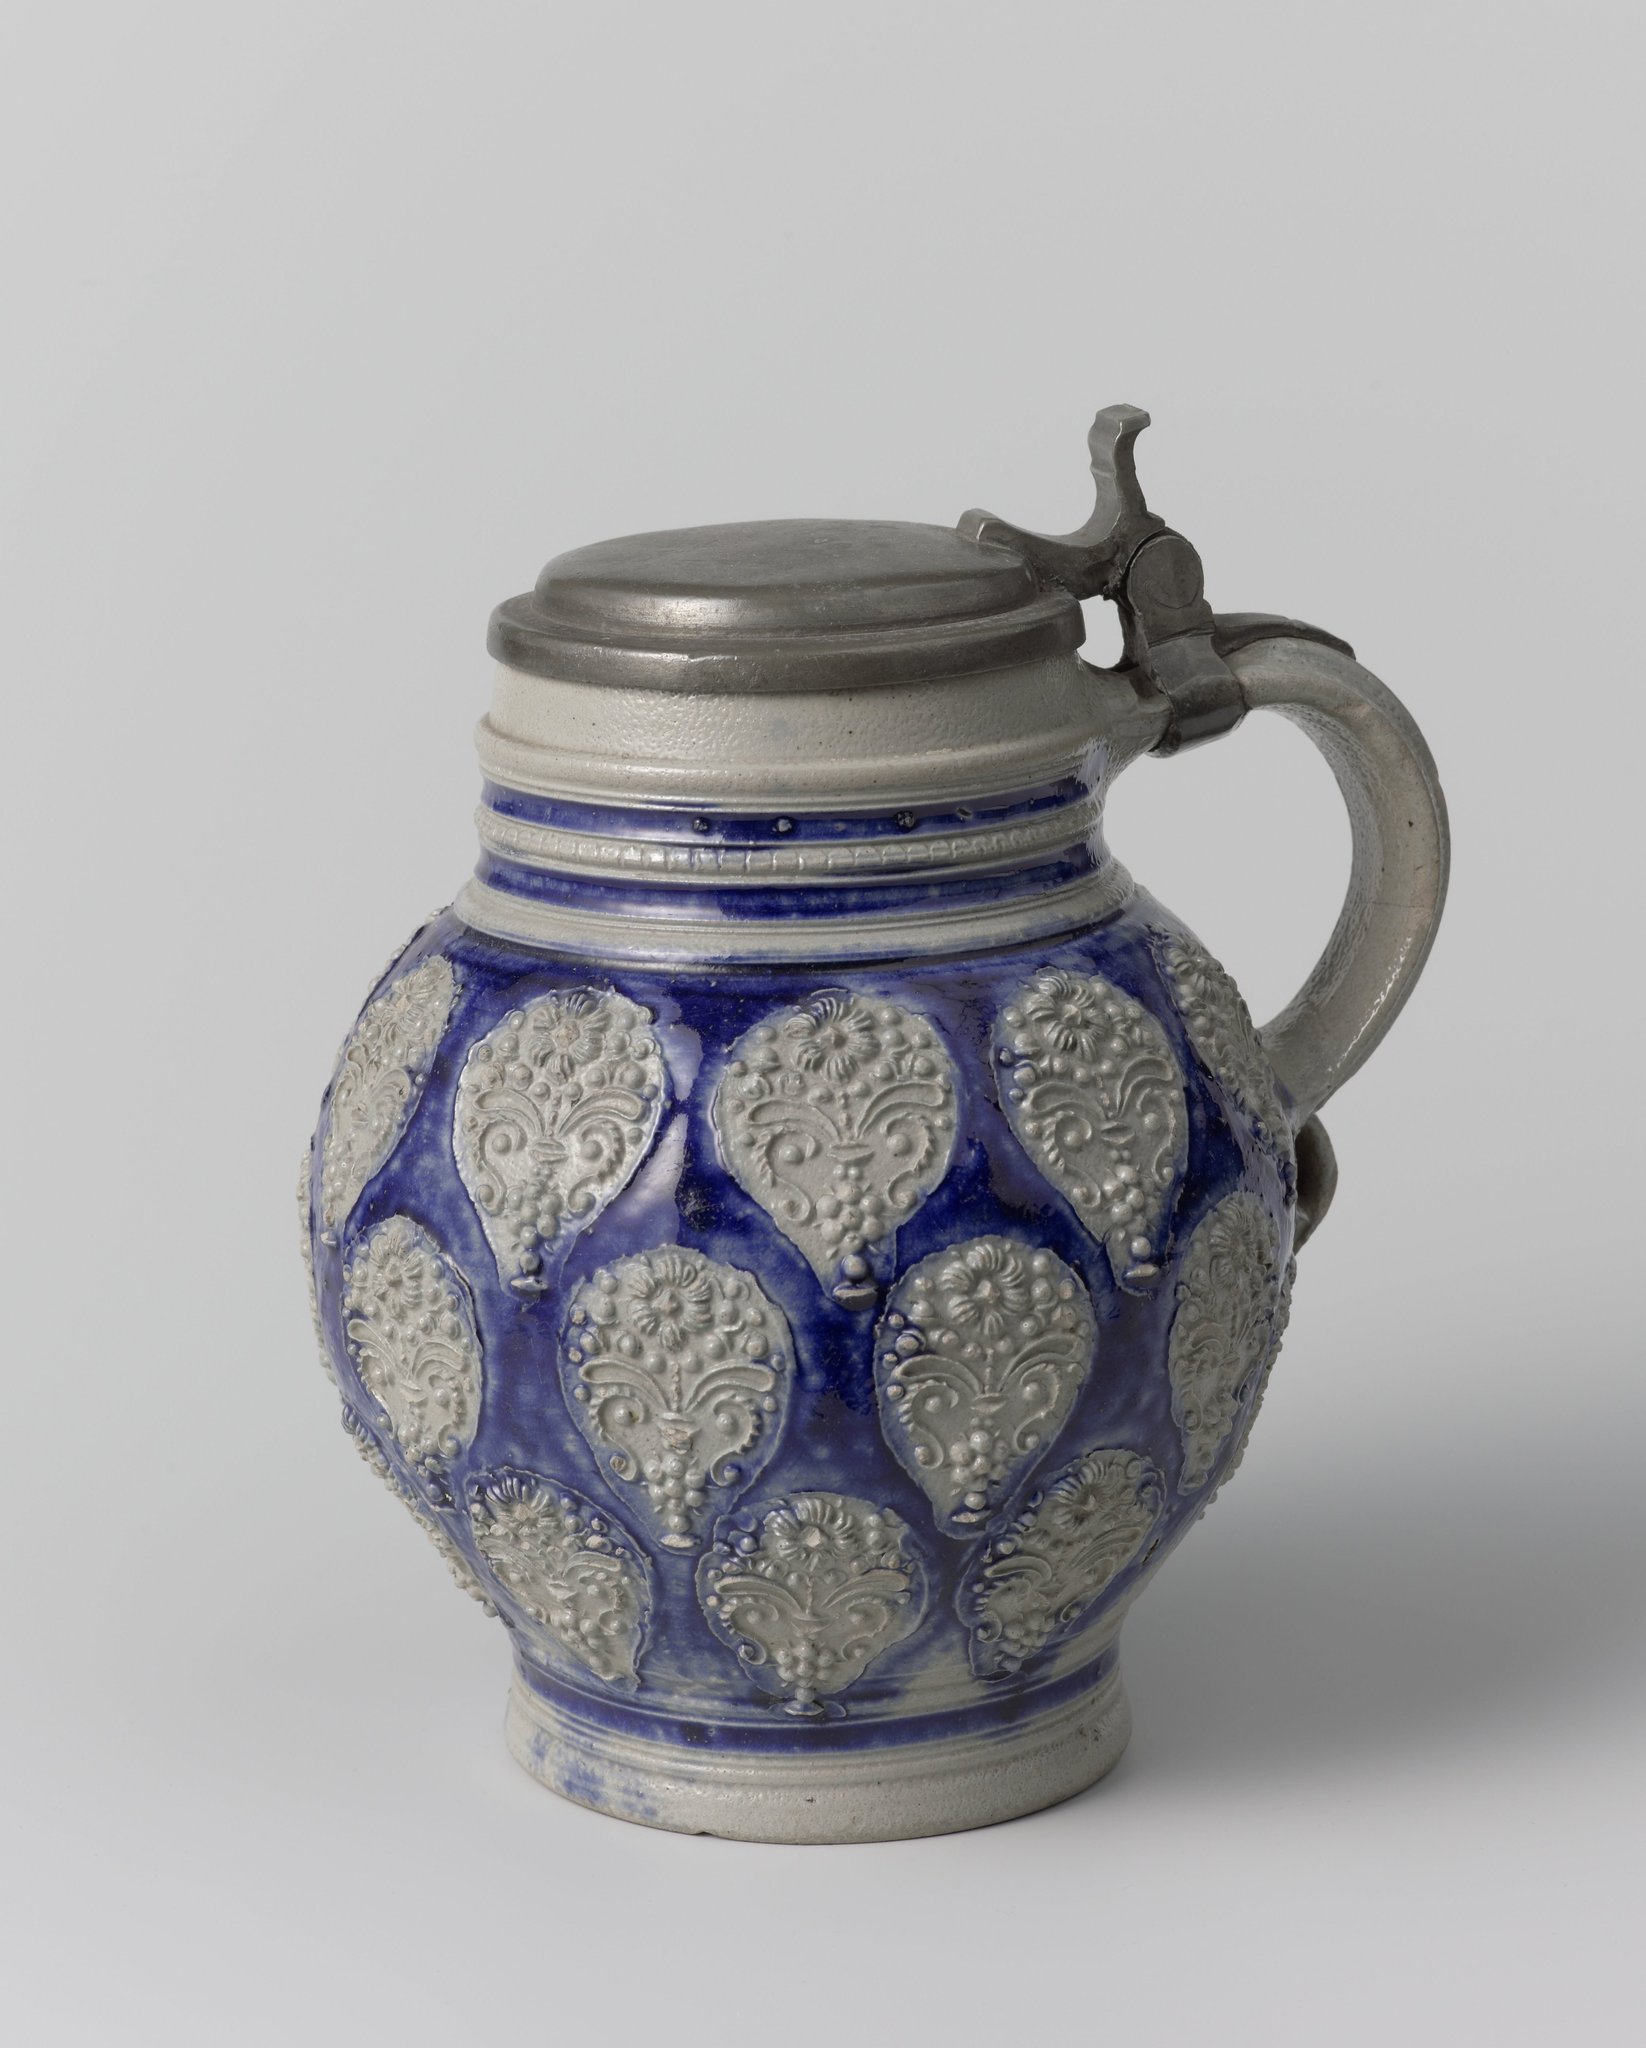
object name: jug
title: Jug with flower vases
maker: Anonymous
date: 1680-1720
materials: cobalt, glaze, stoneware, tin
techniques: firing, forming, relief, turning, vitrification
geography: westerwald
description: Kruik van steengoed op standring met een bolvormige buik en een wijde, korte nek. Het C-vormige oor is bevestigd aan de nek en de buik. Enkele profielen en ingegrifte lijnen op de voet en de nek. Gedeeltelijk bedekt met kobaltblauw. Op de buik een reliëfdecoratie van drie rijen met kleine gedrukte en opgelegde medaillons met een bloemenvaas tegen een blauwe achtergrond. Aan het oor is een tinnen montuur met een deksel bevestigd. Westerwald.